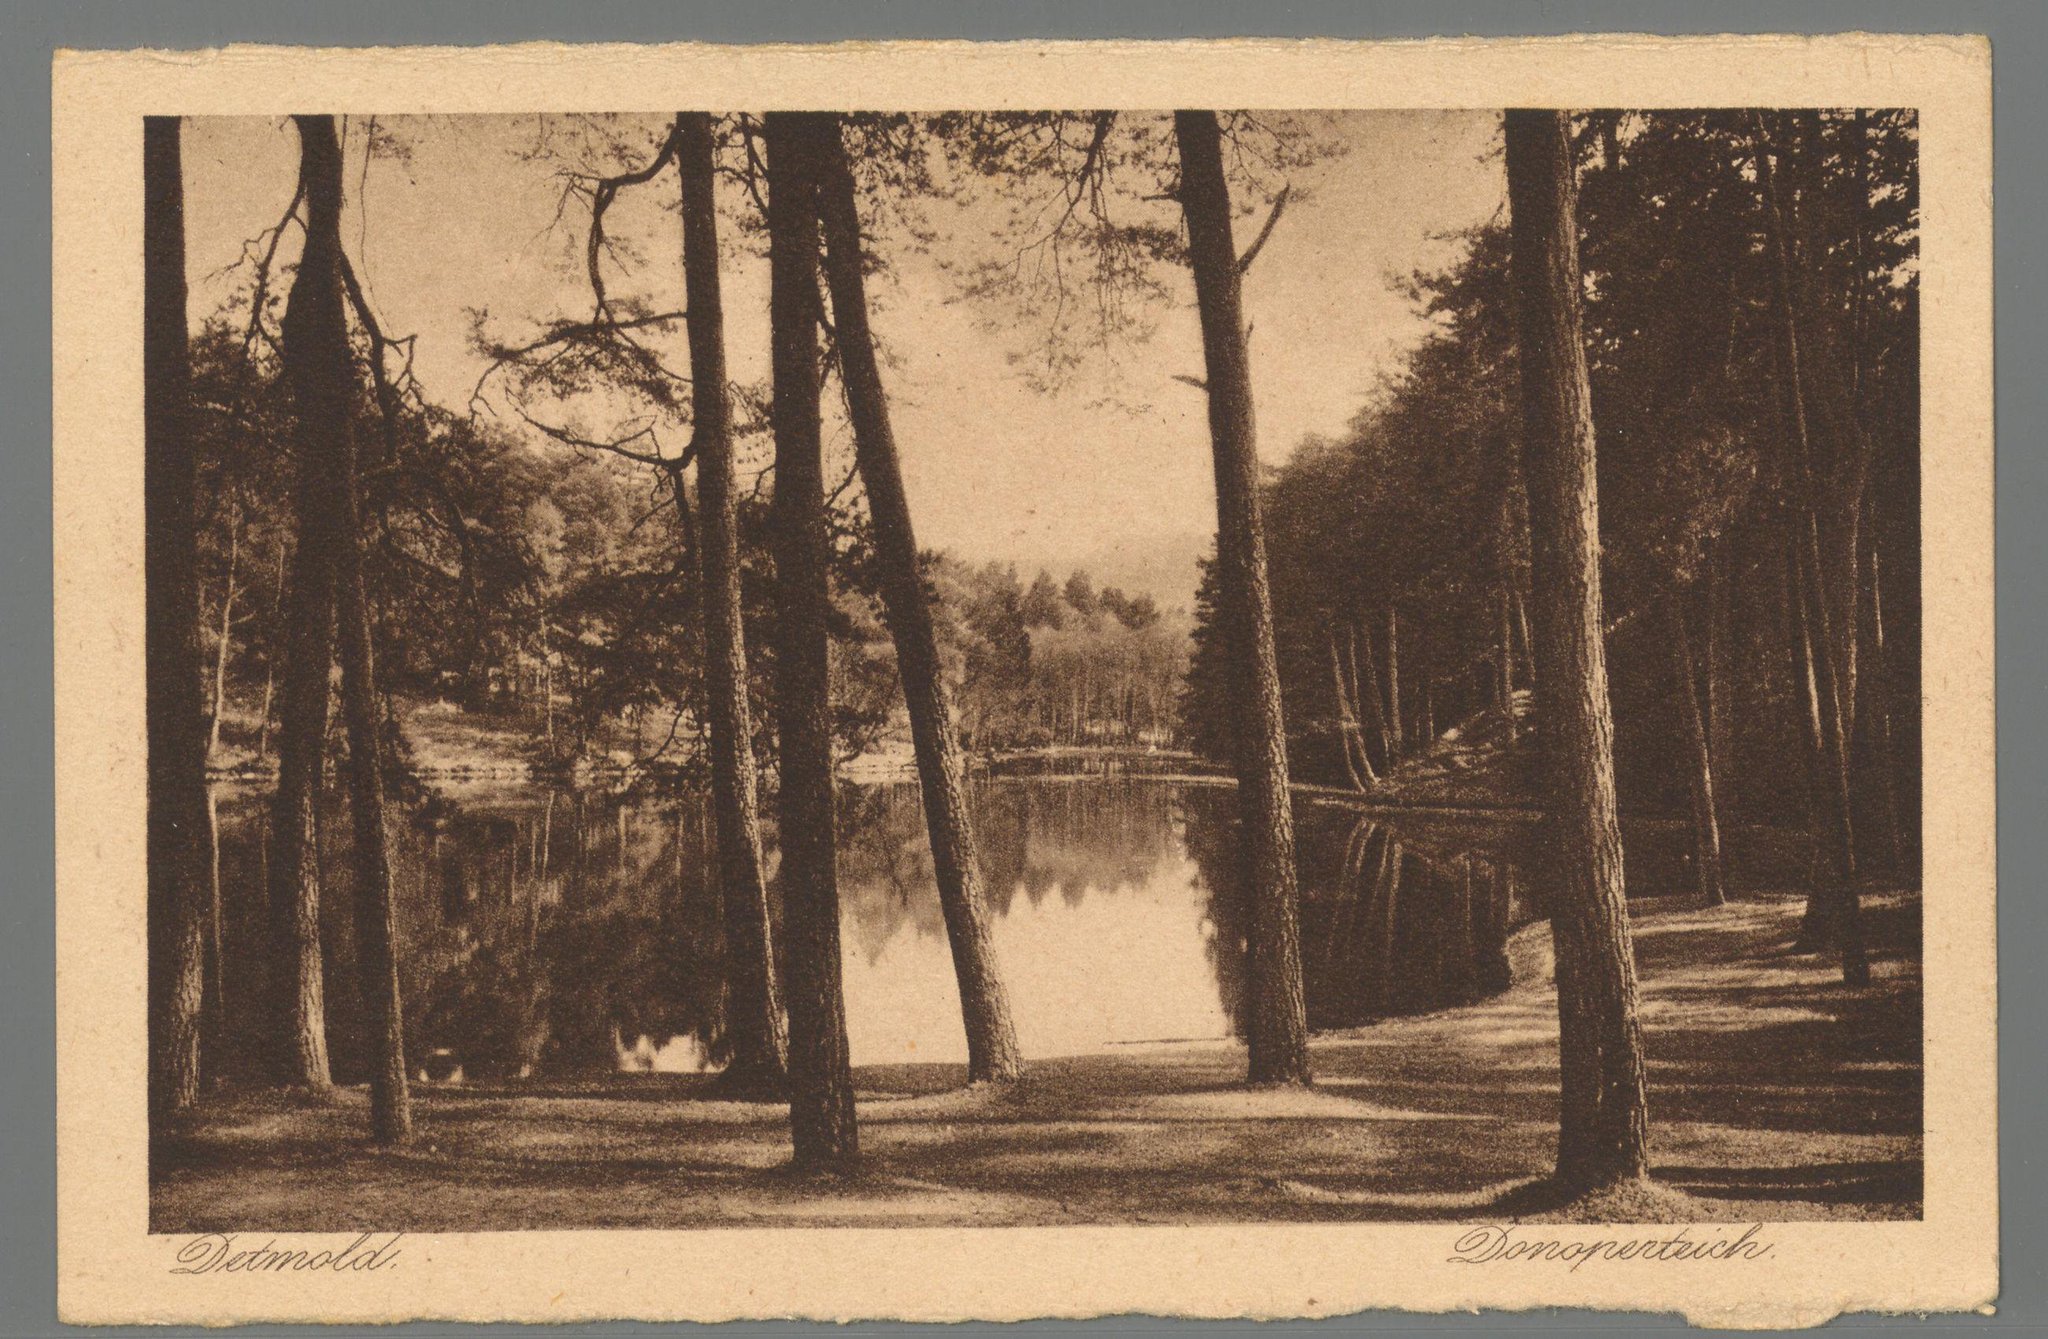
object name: ansichtkaart, prentbriefkaart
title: Detmold. Donoperteich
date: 1905-1930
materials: cardboard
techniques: rotogravure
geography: detmold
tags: pond